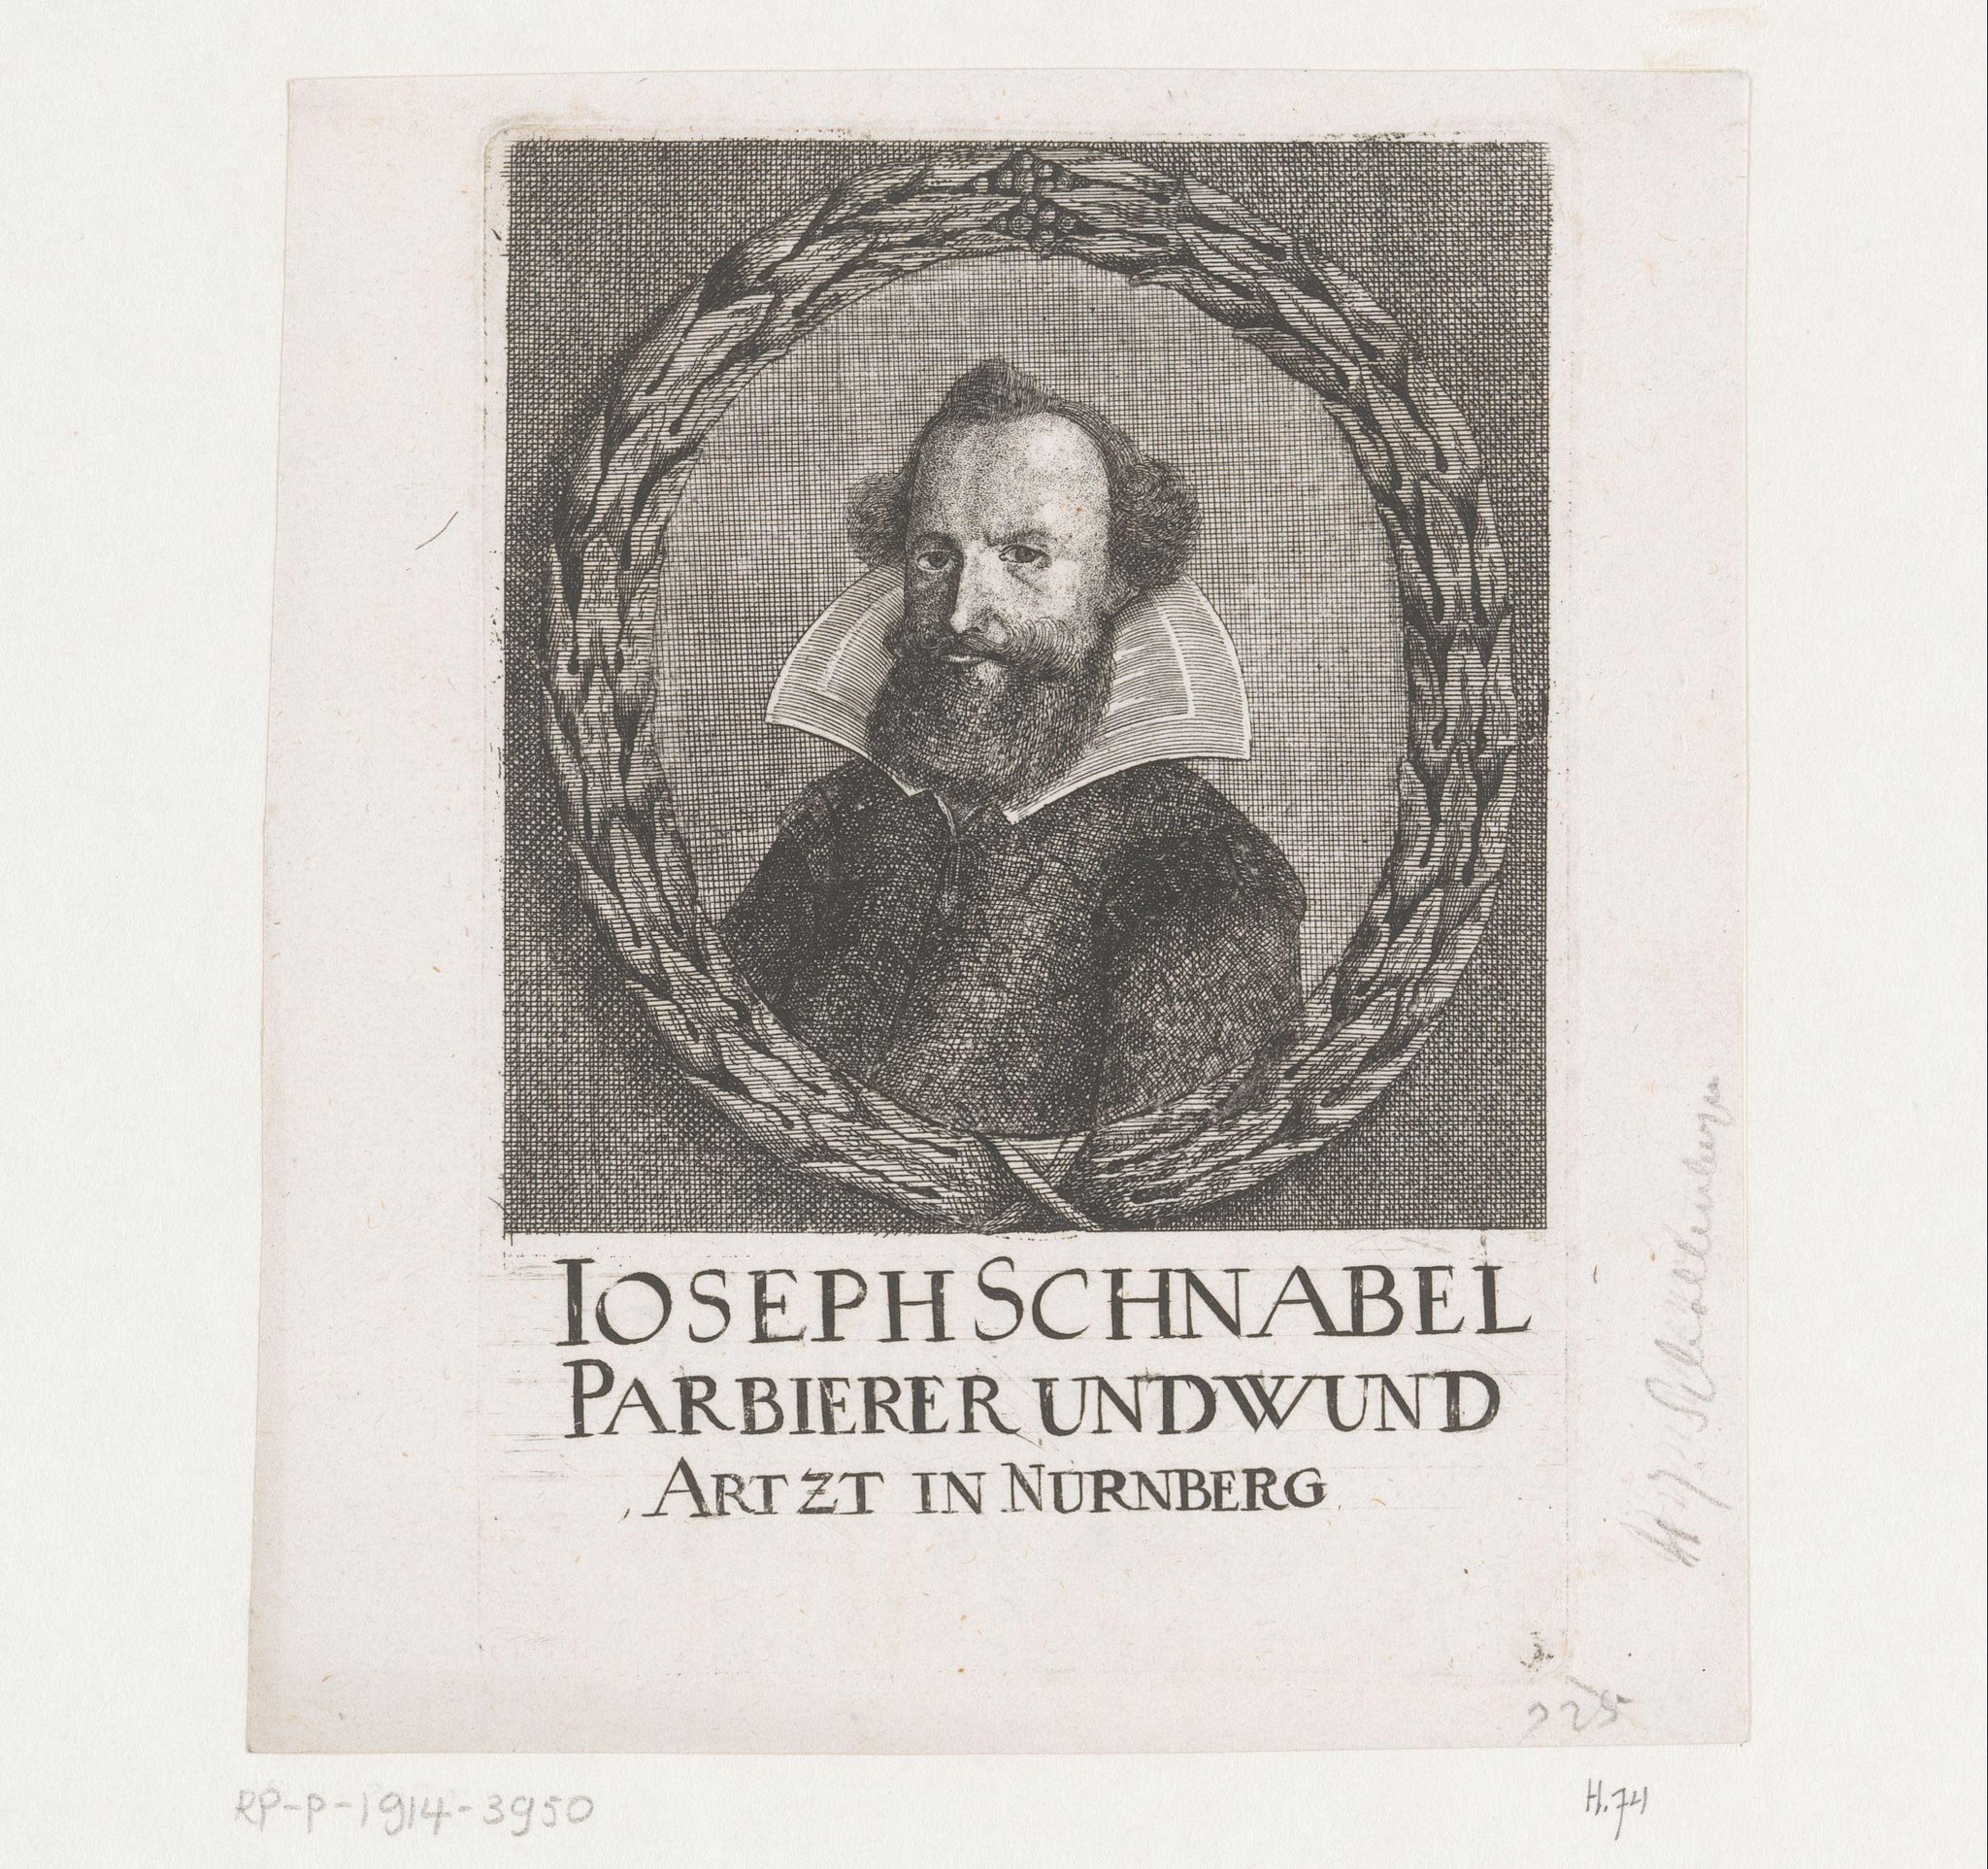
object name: print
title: Portret van Joseph Schnabel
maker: johann jacob schollenberger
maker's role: print maker, publisher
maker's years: 1646-1689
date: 1656-1689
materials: paper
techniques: engraving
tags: historical persons, physician, doctor (+ portrait of scholar, scientist)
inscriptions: collector's mark: Lugt 2228